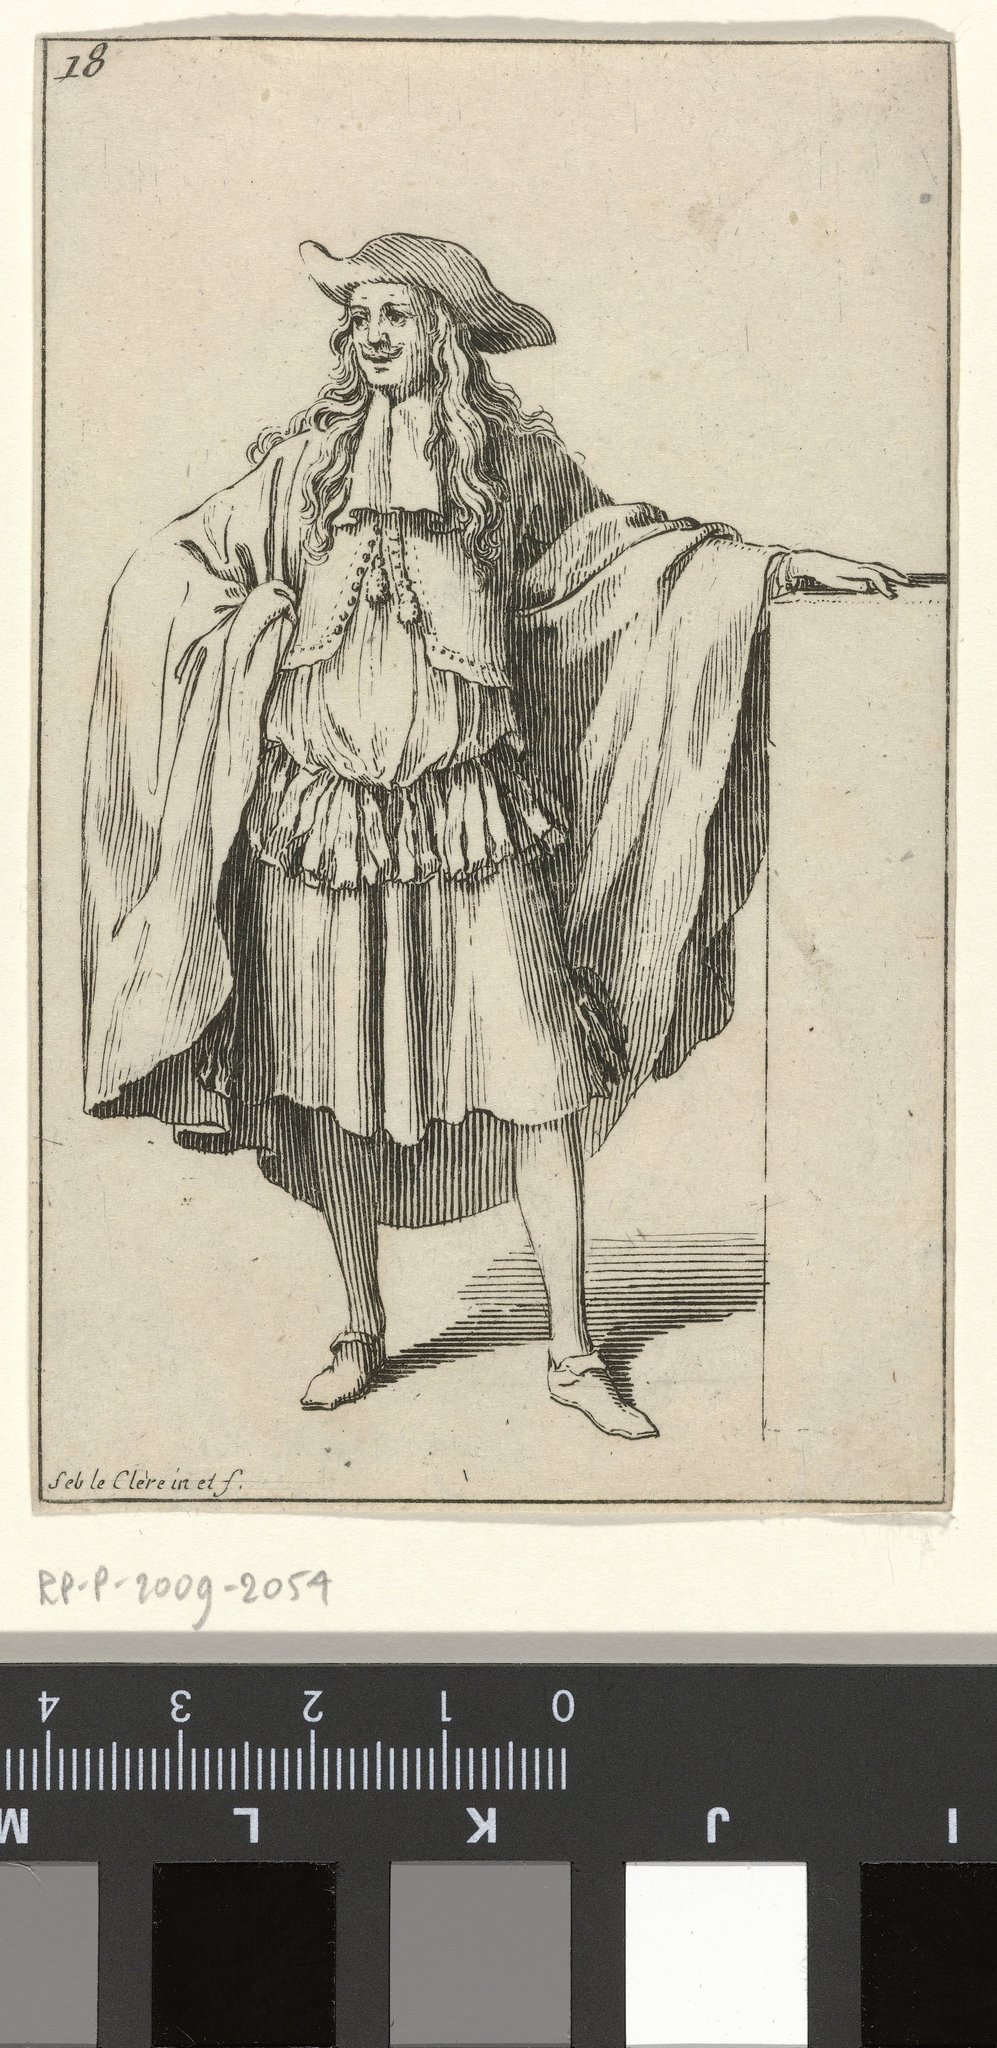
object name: print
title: Man bij muurtje, gekleed in een rhingrave kostuum en wijde mantel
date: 1685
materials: paper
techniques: etching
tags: clothing for the upper part of the body (with name) (+ men's clothes), neck-gear: jabot (+ men's clothes), styles of hairdress (allonge), cape (+ men's clothes), clothing for the upper part of the body (innocent) (+ men's clothes), head-gear: hat (+ men's clothes), fashion plates, shoes, sandals (+ men's clothes), clothing for the upper part of the body (doublet) (+ men's clothes), stockings, socks (+ men's clothes), trousers, breeches, etc. (petticoat breeches) (+ men's clothes), france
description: Staande man gekleed in een rhingrave kostuum, bestaande uit een kort wambuis (innocent), rechthoekige bef met akertjes, hemd, wijde kniebroek met aan weerszijden linten en kousen. Om de schouders en armen is een wijde mantel gedrapeerd. Hoed met brede slappe rand op het allongekapsel. Platte schoenen. Deze prent is de 5de staat van nummer 18, en behoort tot een serie van ca. 24 kostuumprenten, uit Figures a la mode dédiées a Mr Le Duc de Bourgogne, uitgegeven door Etienne Jeaurat, Parijs, ca. 1685.